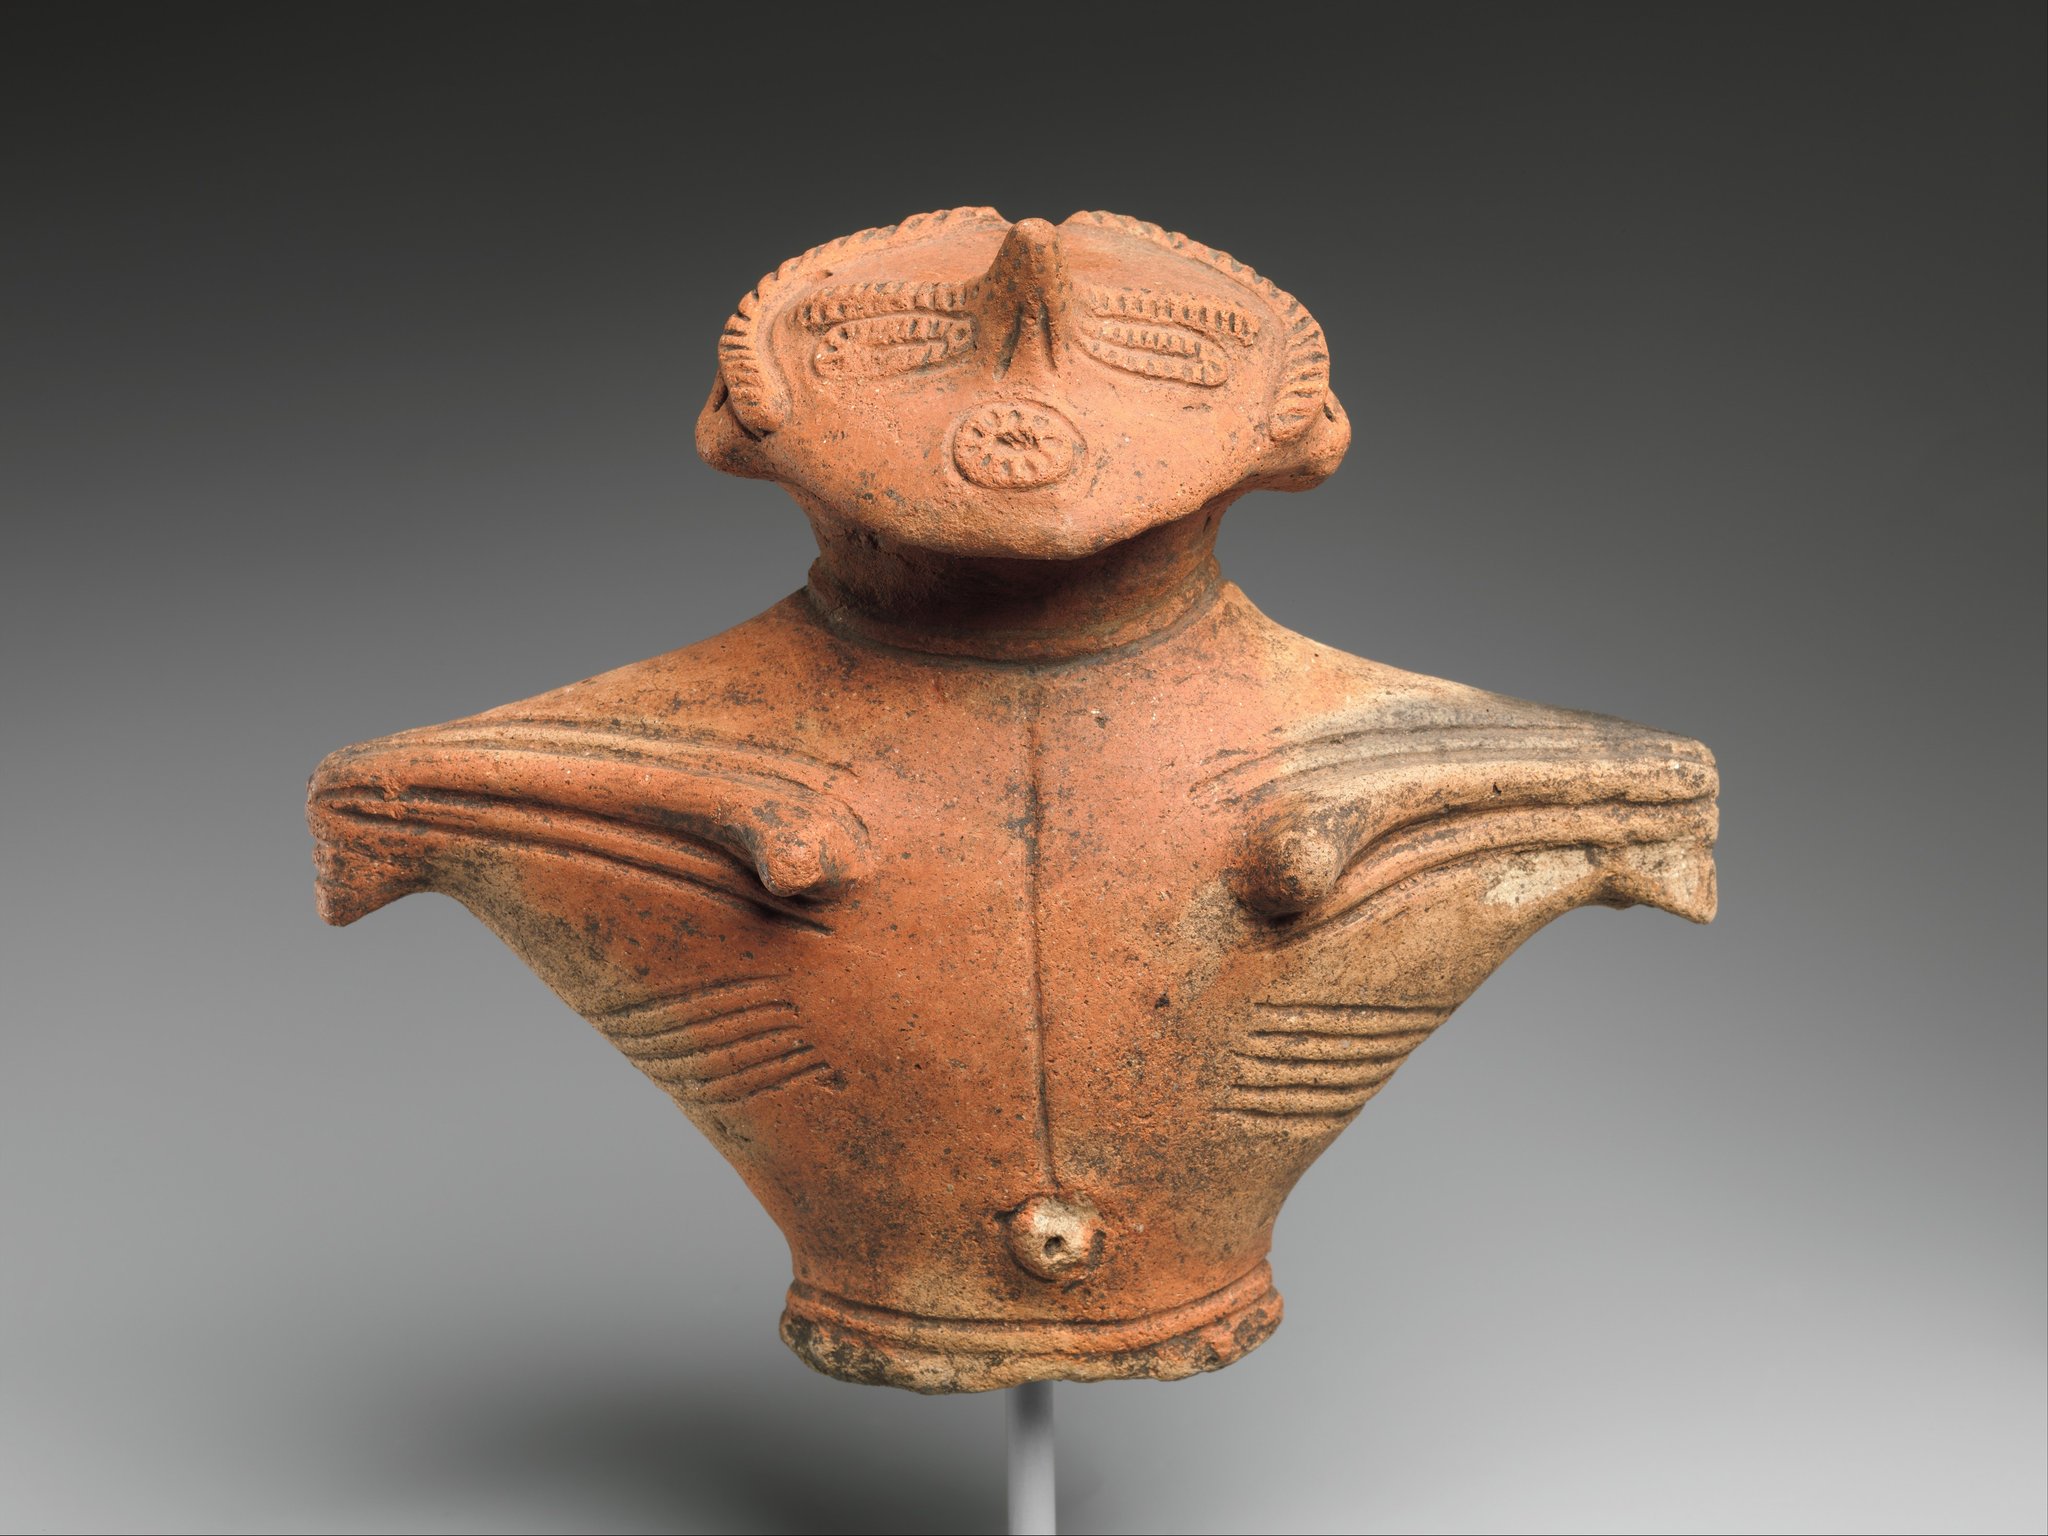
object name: figurine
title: Dogū (Clay Figurine)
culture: japanese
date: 1000-300 BCE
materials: cord, earthenware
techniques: incising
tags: human figures